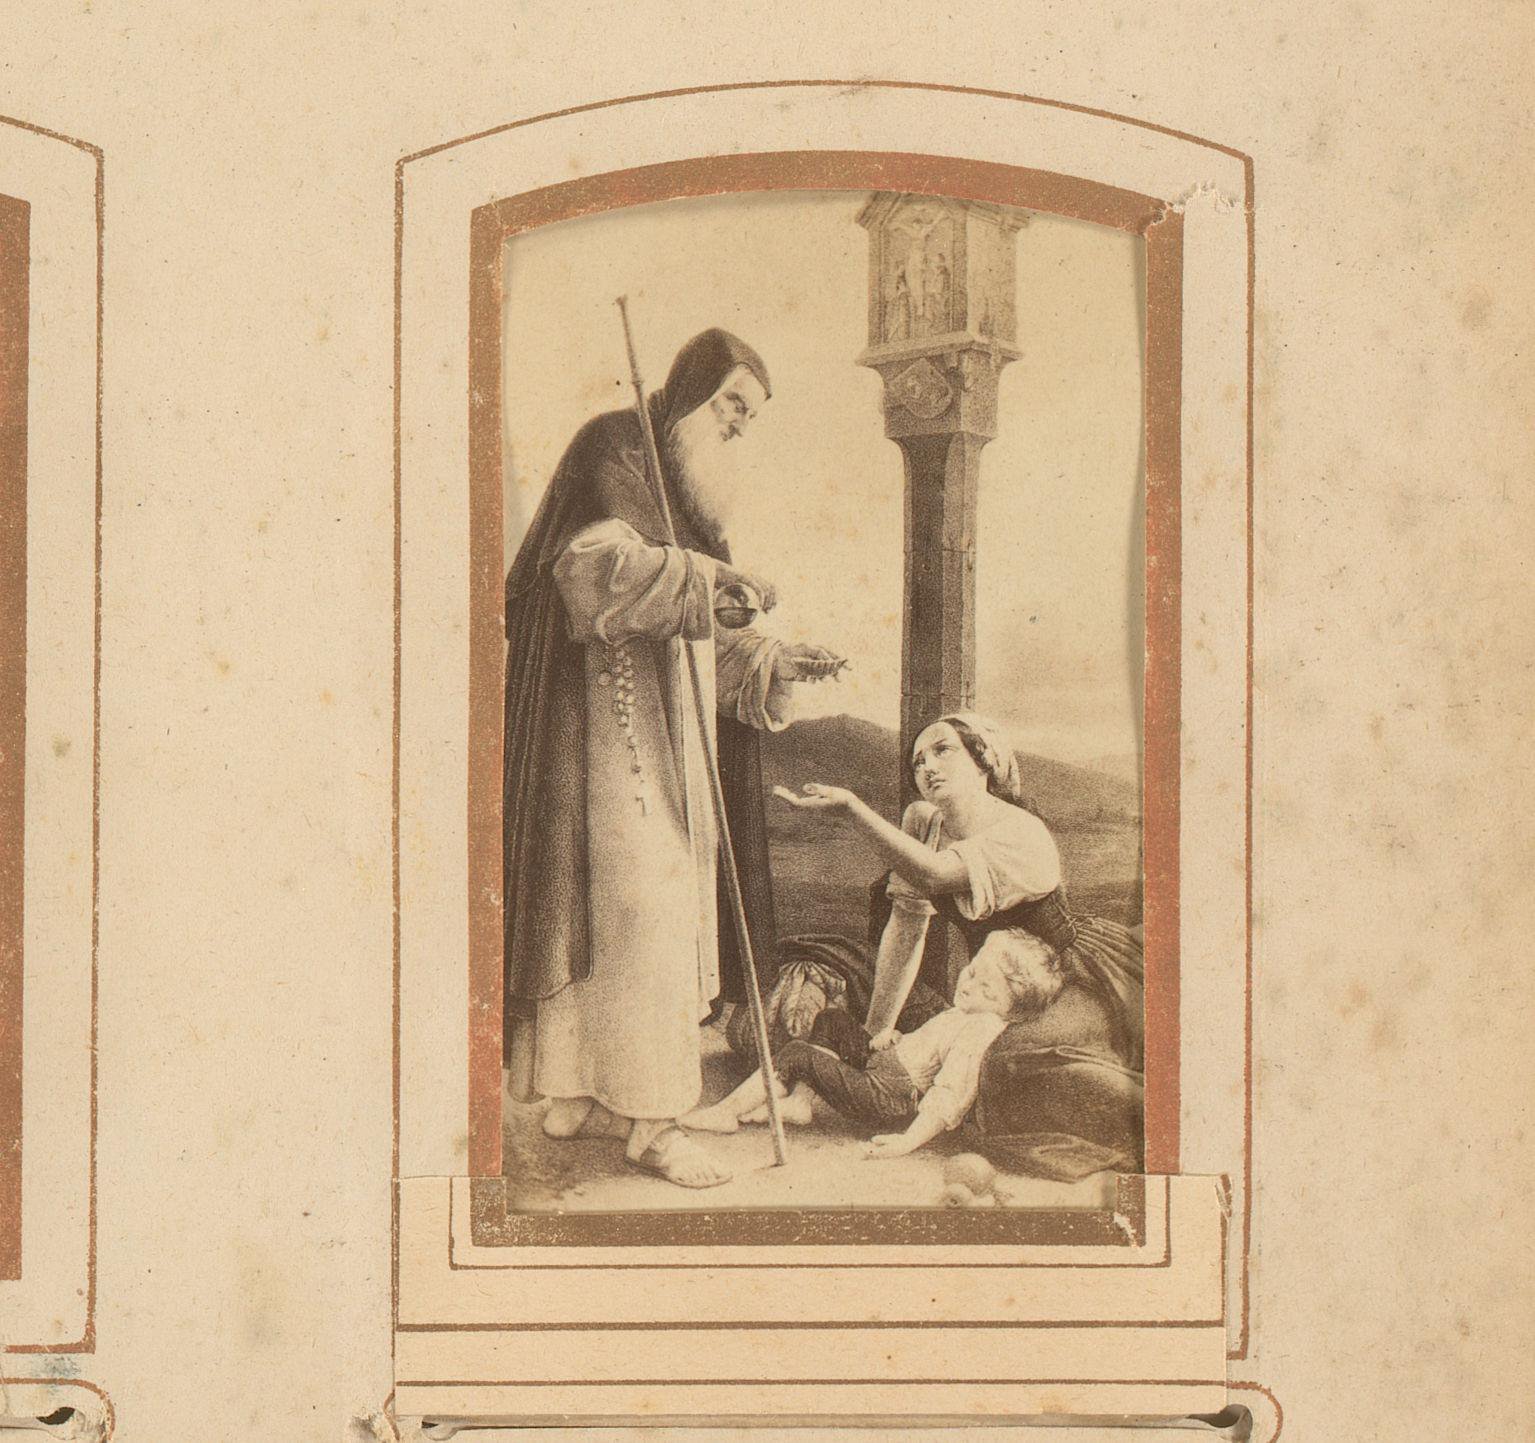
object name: carte de visite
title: Fotoreproductie van een schilderij van een liefdadige monnik door Eduard Daege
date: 1850-1900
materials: cardboard, photographic support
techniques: albumen print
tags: charity, 'caritas'; 'carità' (ripa) ~ one of the three theological virtues, adult woman, monk(s), friar(s)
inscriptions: inscription: ‘170./ Daege./ Le moine charitable./ Der wohlthätige Mönch./ The charitable monk.’